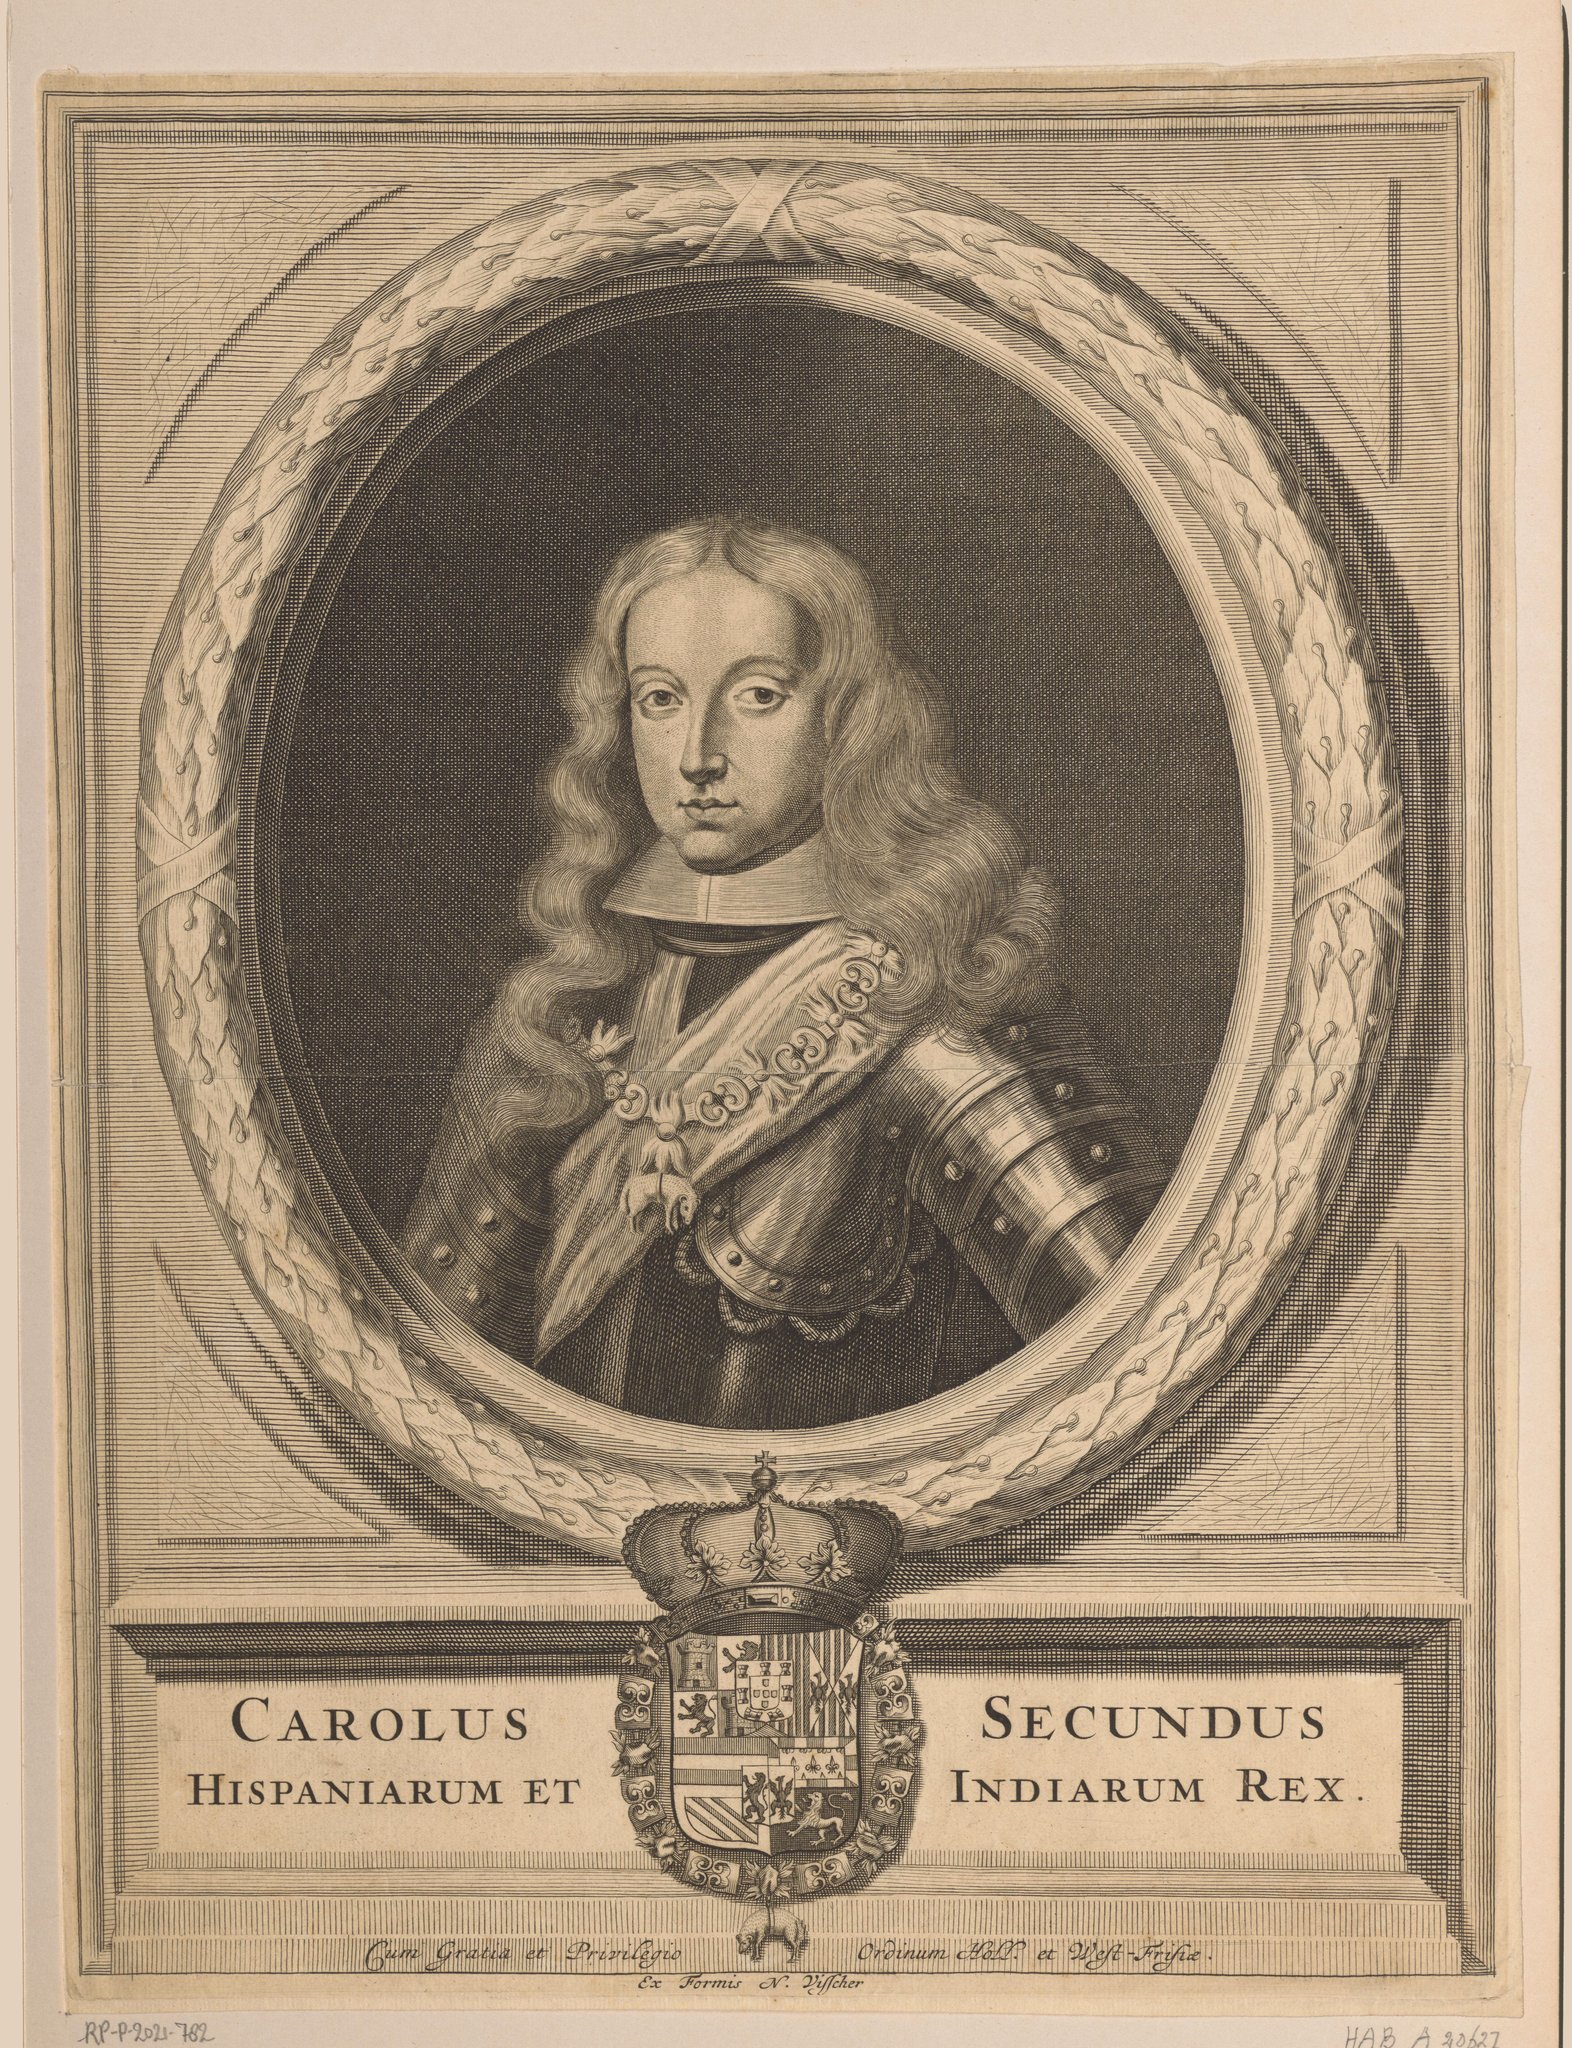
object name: print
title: Portret van Karel II, koning van Spanje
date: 1679-1720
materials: paper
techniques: engraving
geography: netherlands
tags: karel ii (koning van spanje), historical persons, knighthood order of the golden fleece, king, armorial bearing, heraldry